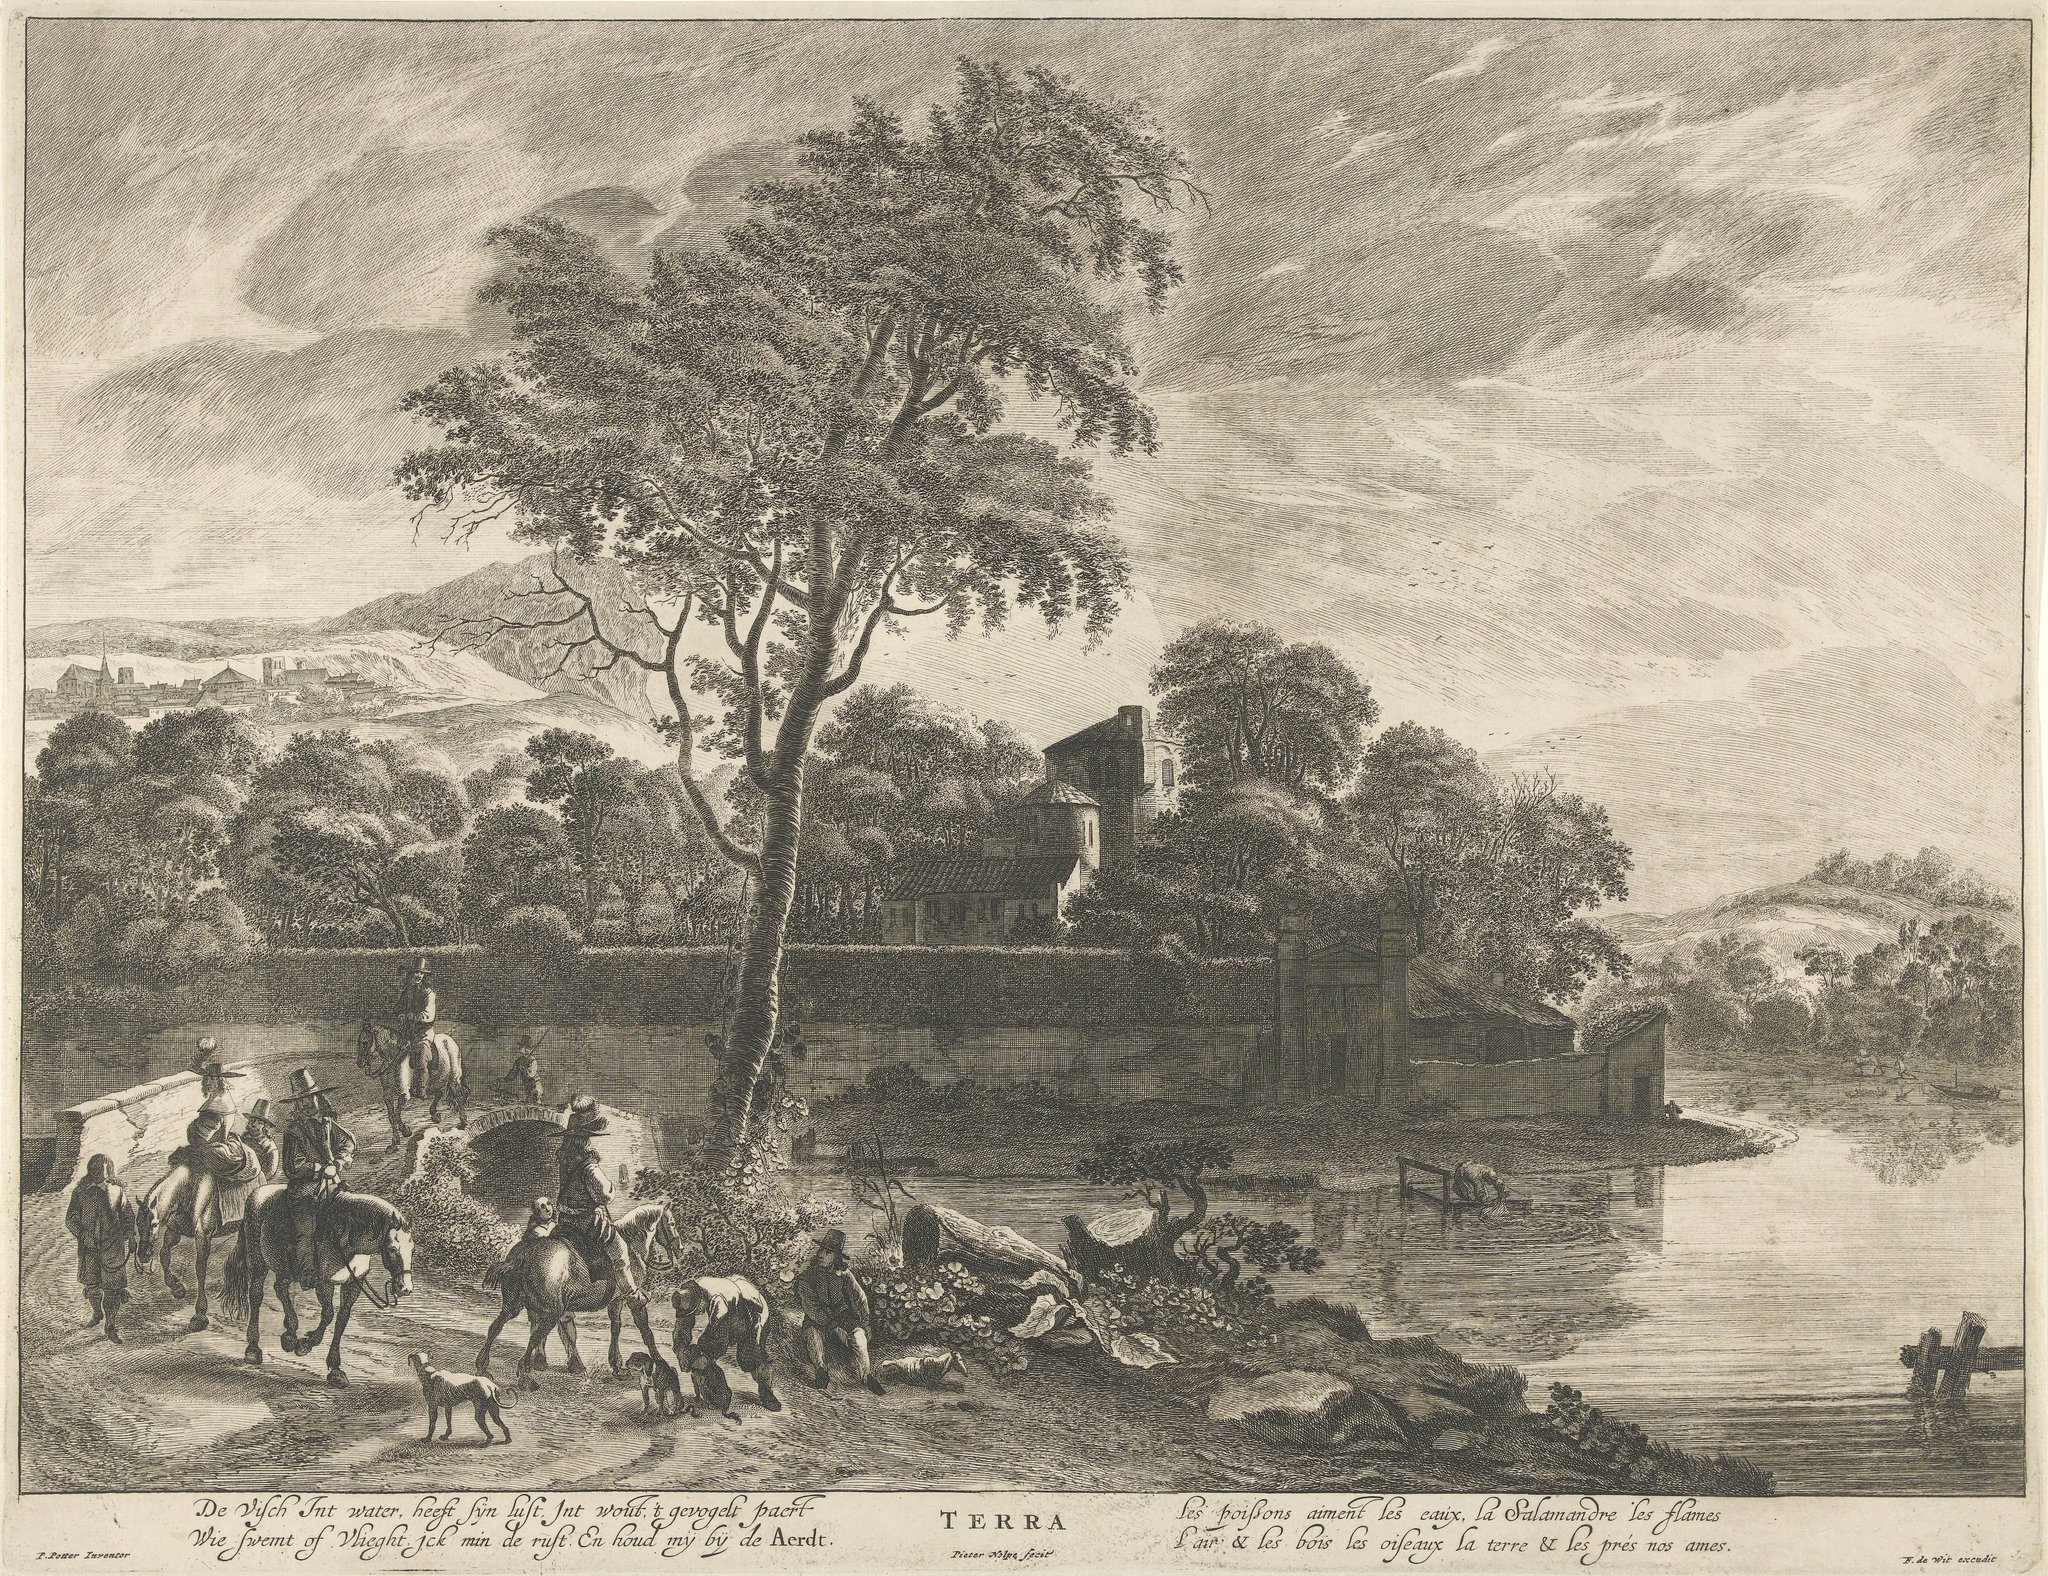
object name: print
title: Landschap met jagers: het element aarde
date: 1640-1706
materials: paper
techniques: engraving, etching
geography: amsterdam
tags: earth (one of the four elements), hunting, chase, hunting dogs, fisherman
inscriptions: collector's mark: Lugt 2228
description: In een landschap rijden jagers te paard over de weg. Een aantal van hen rusten in het gras met de jachthonden. Op de steiger zit een visser met een visnet. Onderaan in de marge een tweeregelig vers in het Nederlands en een tweeregelig vers in het Frans. Prent uit een serie van verschillende maanden, die eveneens een element of seizoen verbeelden.